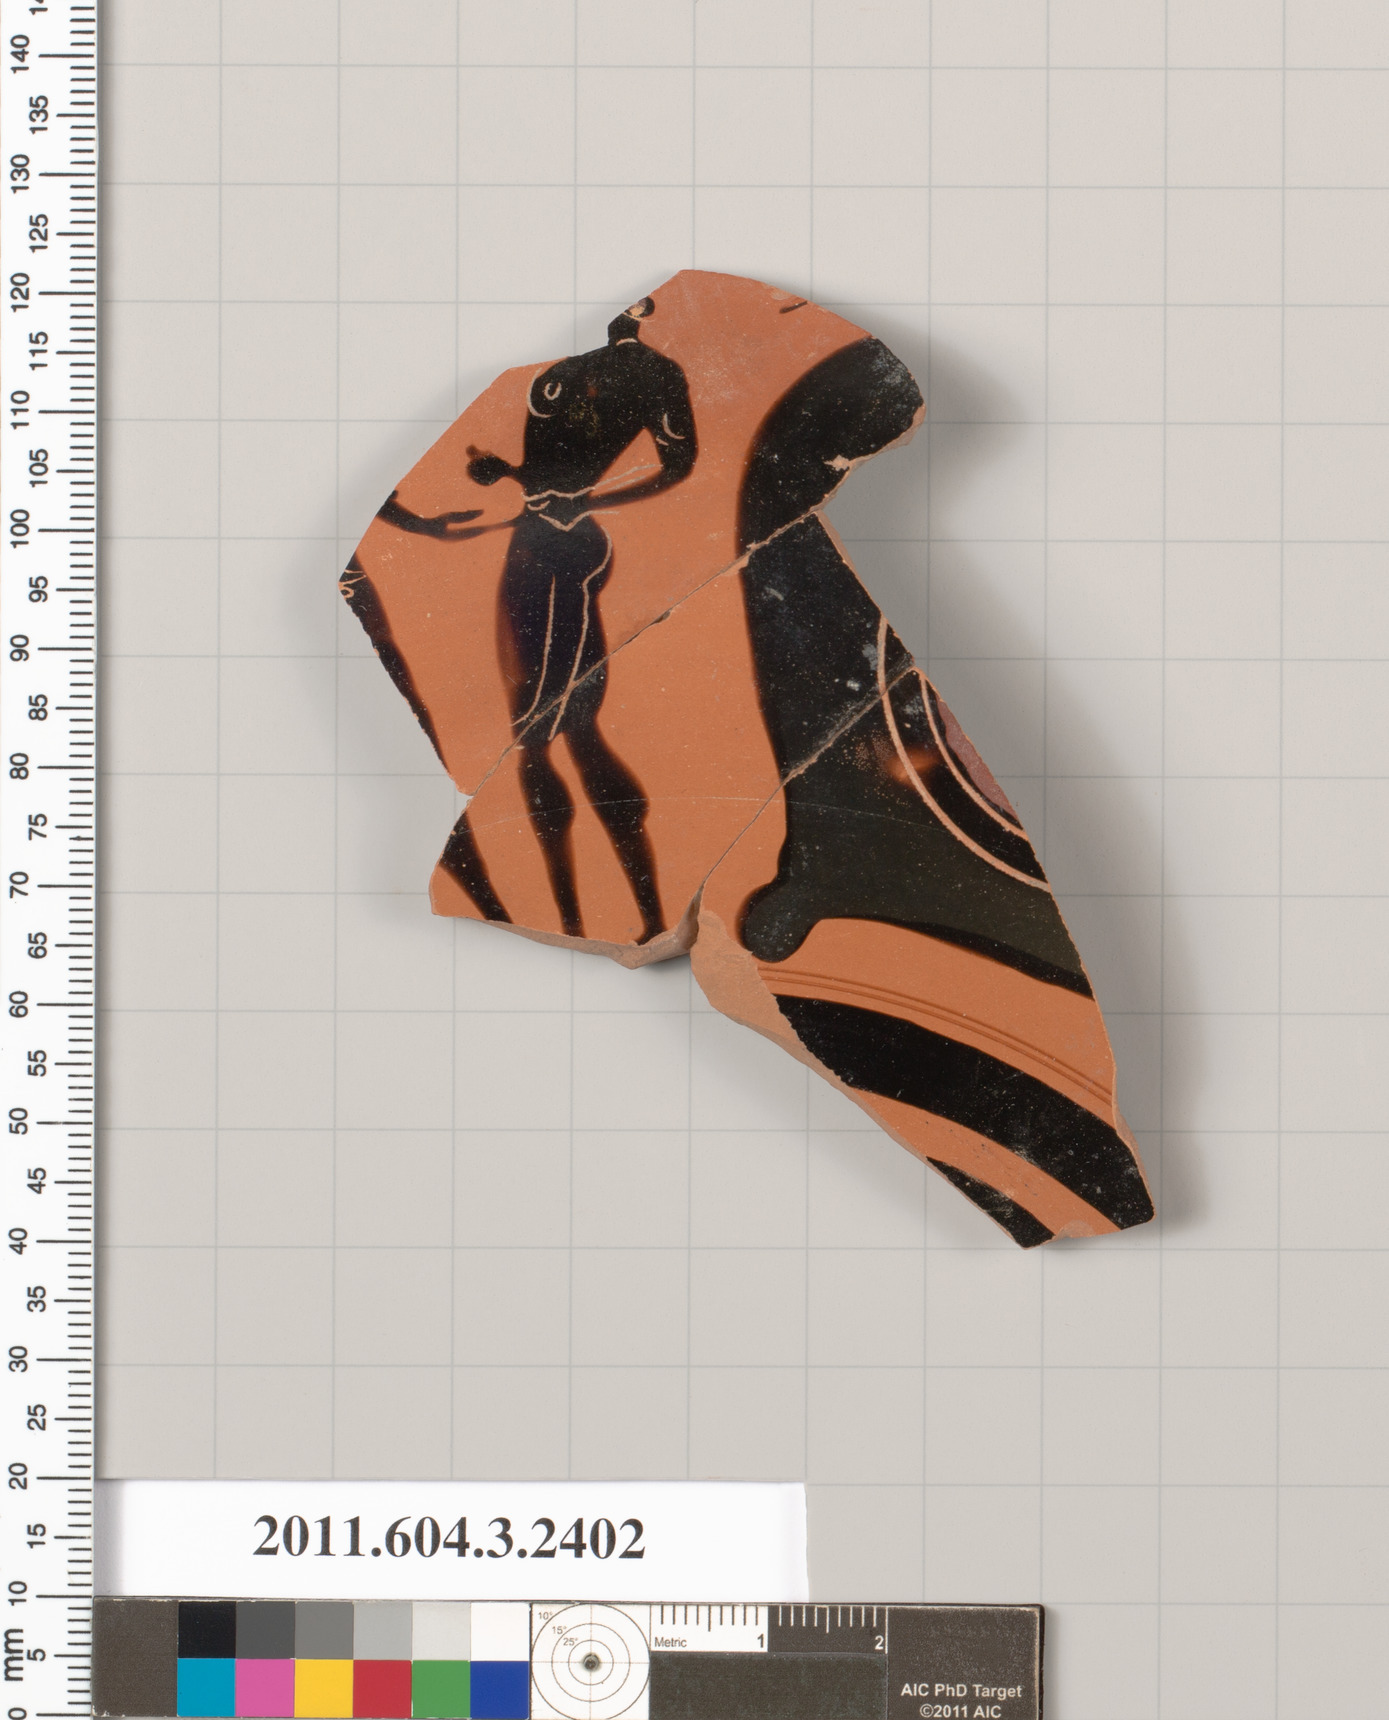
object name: kylix fragment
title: Terracotta fragment of a kylix: eye-cup (drinking cup)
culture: greek, attic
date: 530-510 BCE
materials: terracotta